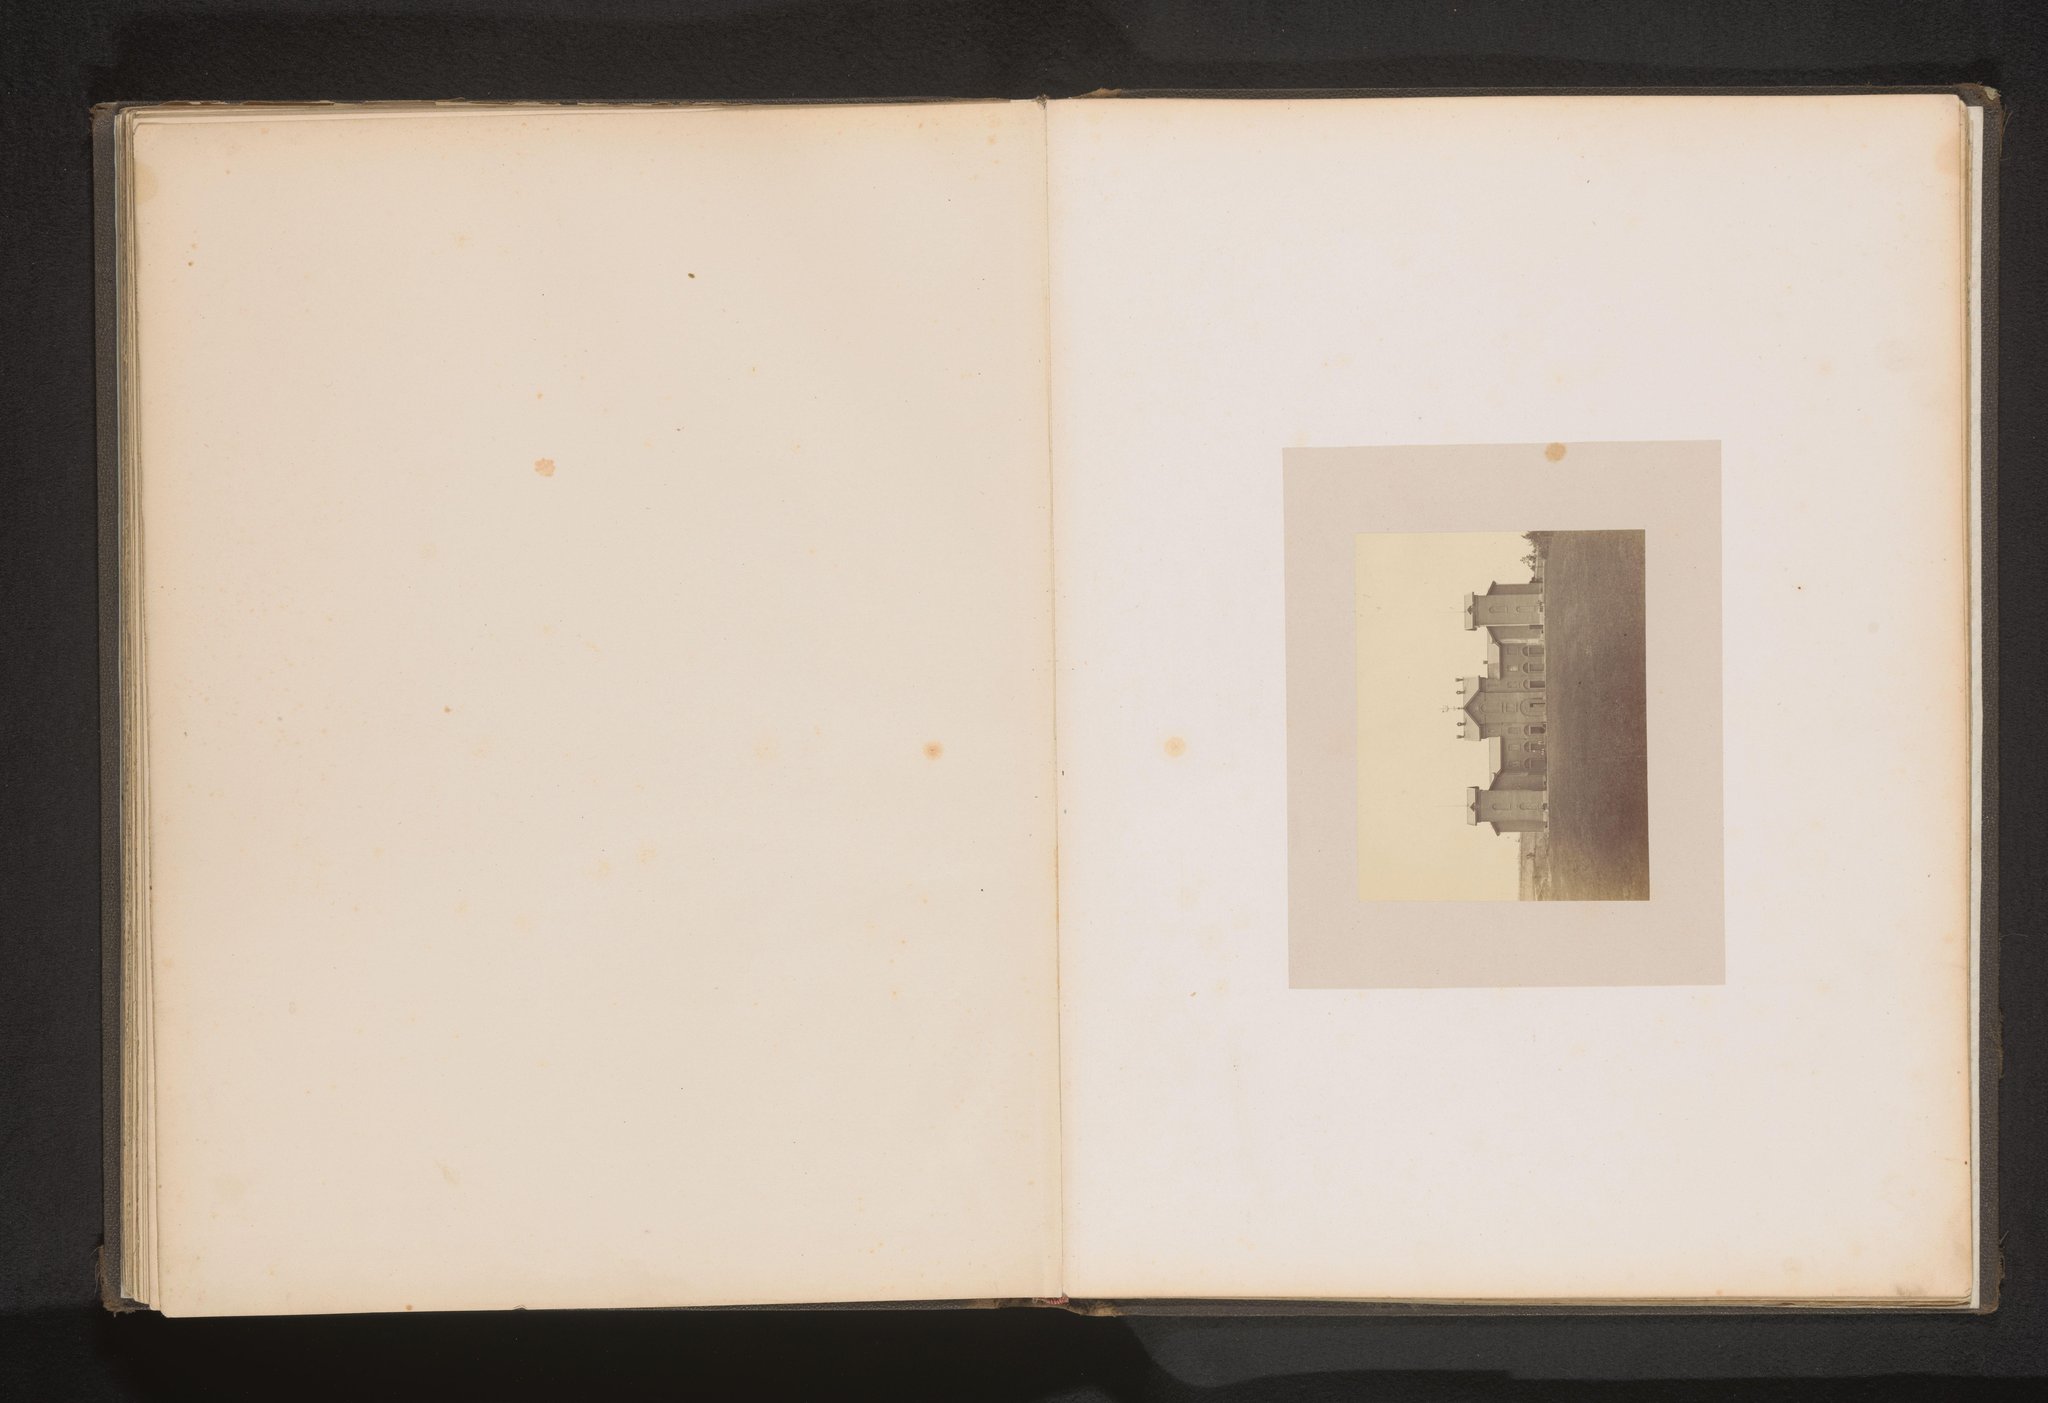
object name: photograph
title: Gezicht op een villa nabij Château de Marlagne te Wépion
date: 1862-1867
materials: photographic support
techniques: albumen print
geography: wépion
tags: villa